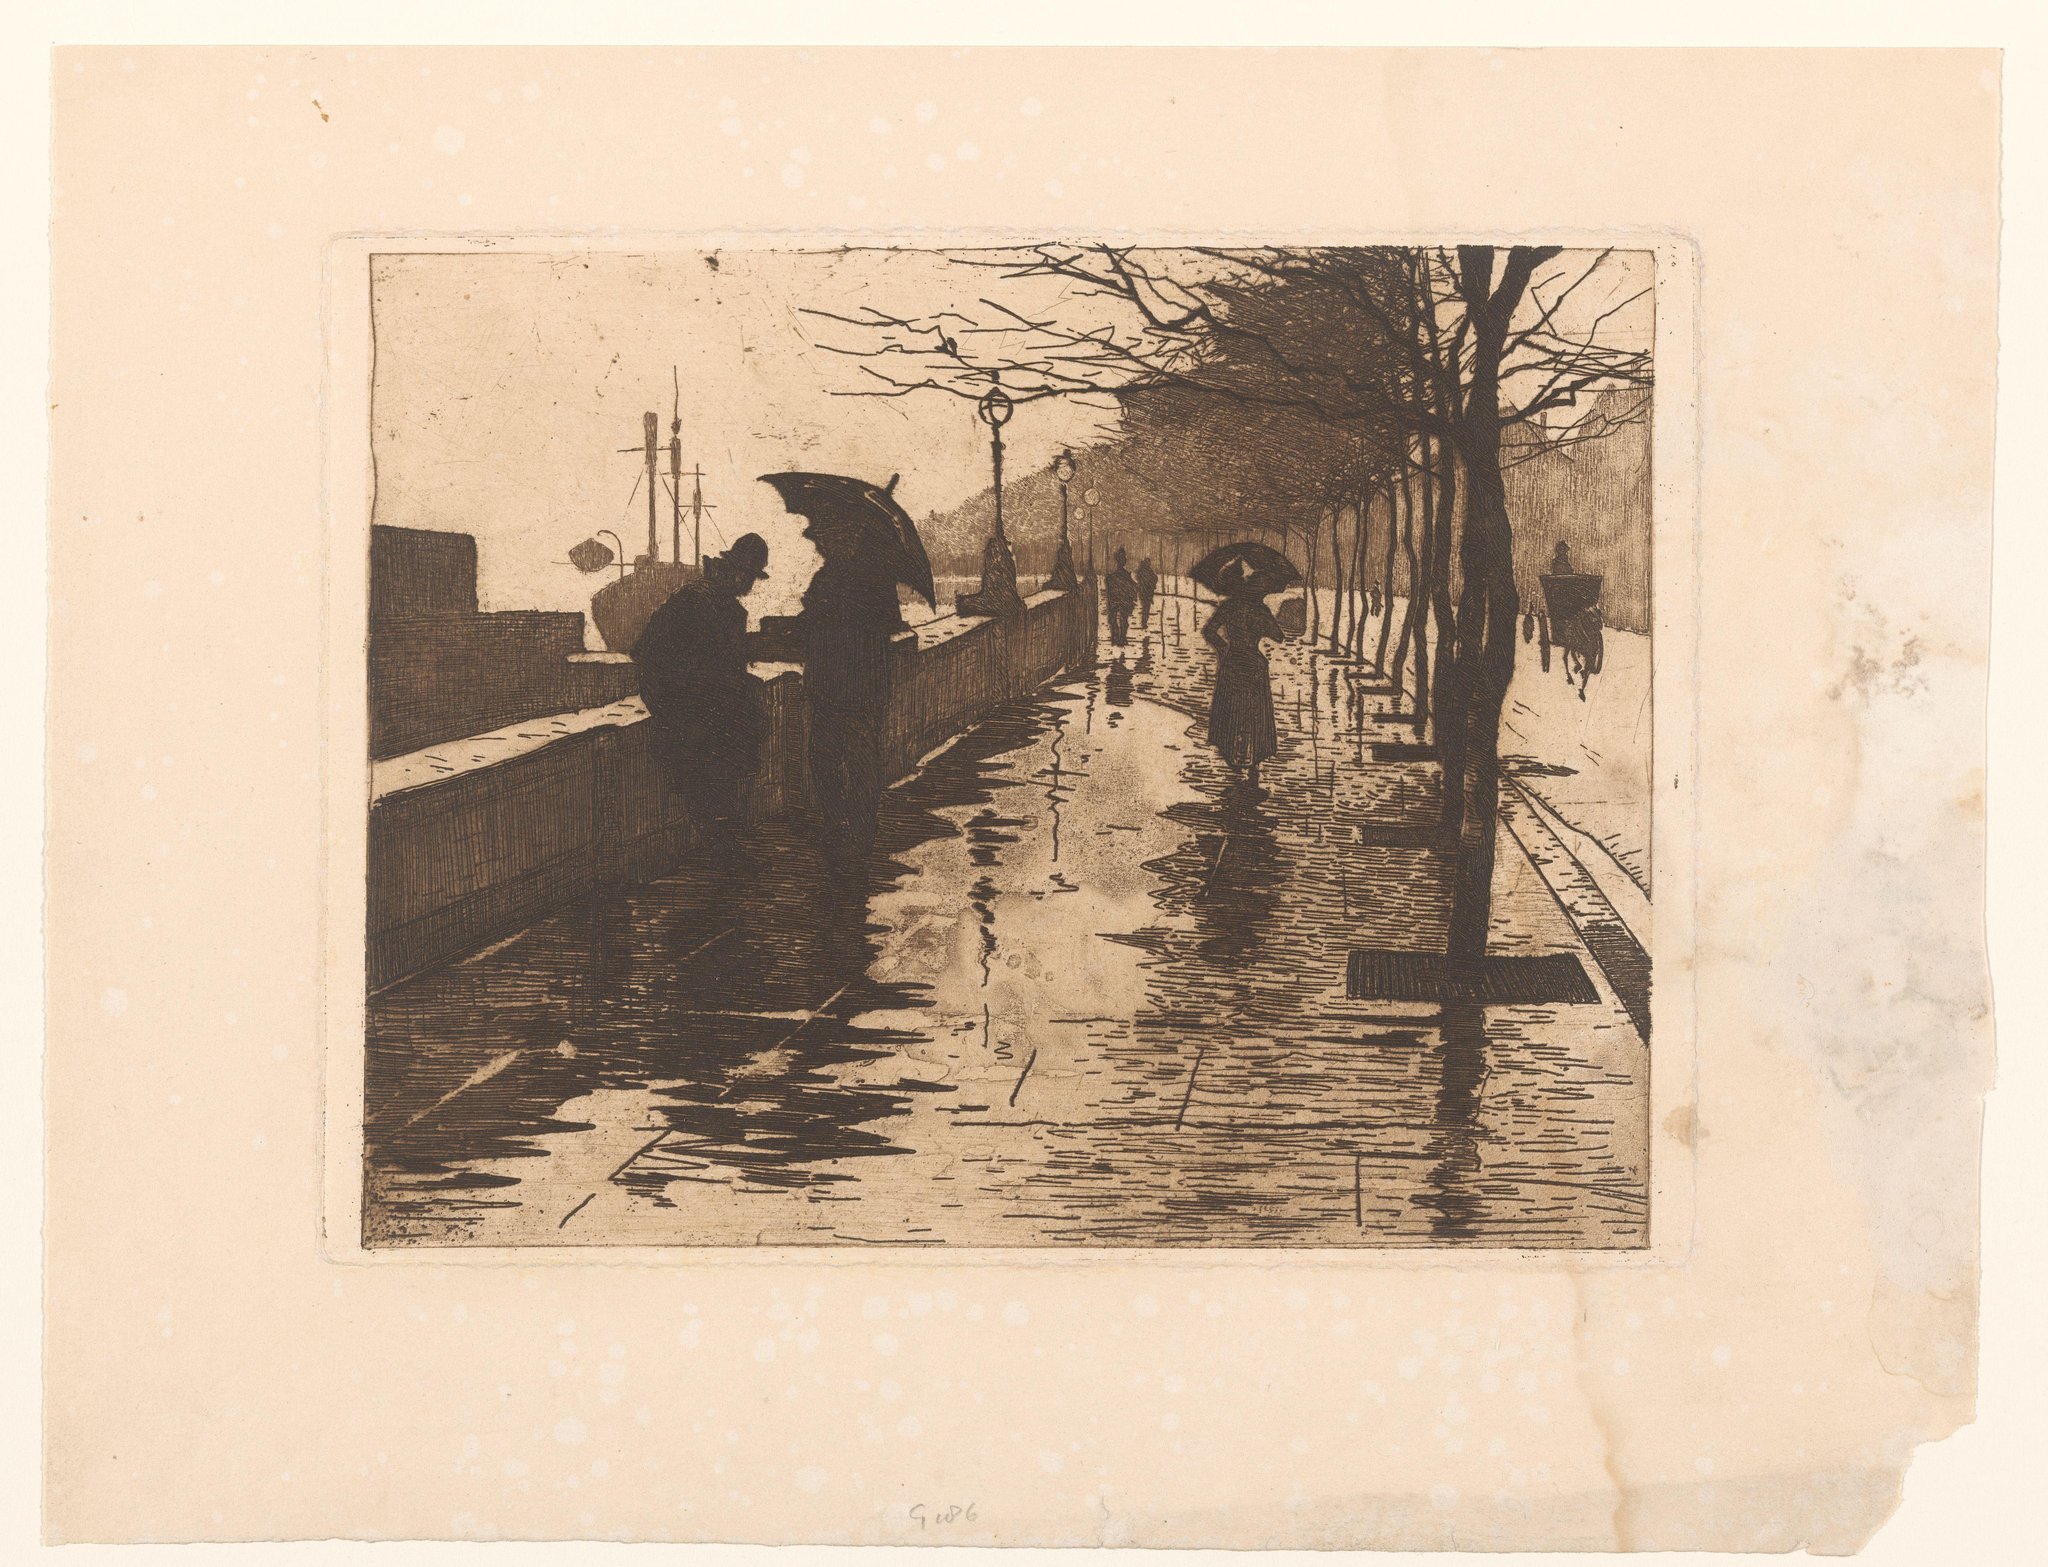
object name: print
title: Gezicht op Victoria Embankment in Londen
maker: willem witsen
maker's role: draughtsman, painter, print maker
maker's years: 1860-1923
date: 1890-1908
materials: paper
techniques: aquatint, etching, intaglio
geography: london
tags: city-view in general; 'veduta', river, public road, thames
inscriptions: collector's mark: Lugt 2228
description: Een rijtuig en wandelaars in de regen. Links een schip in de Theems.